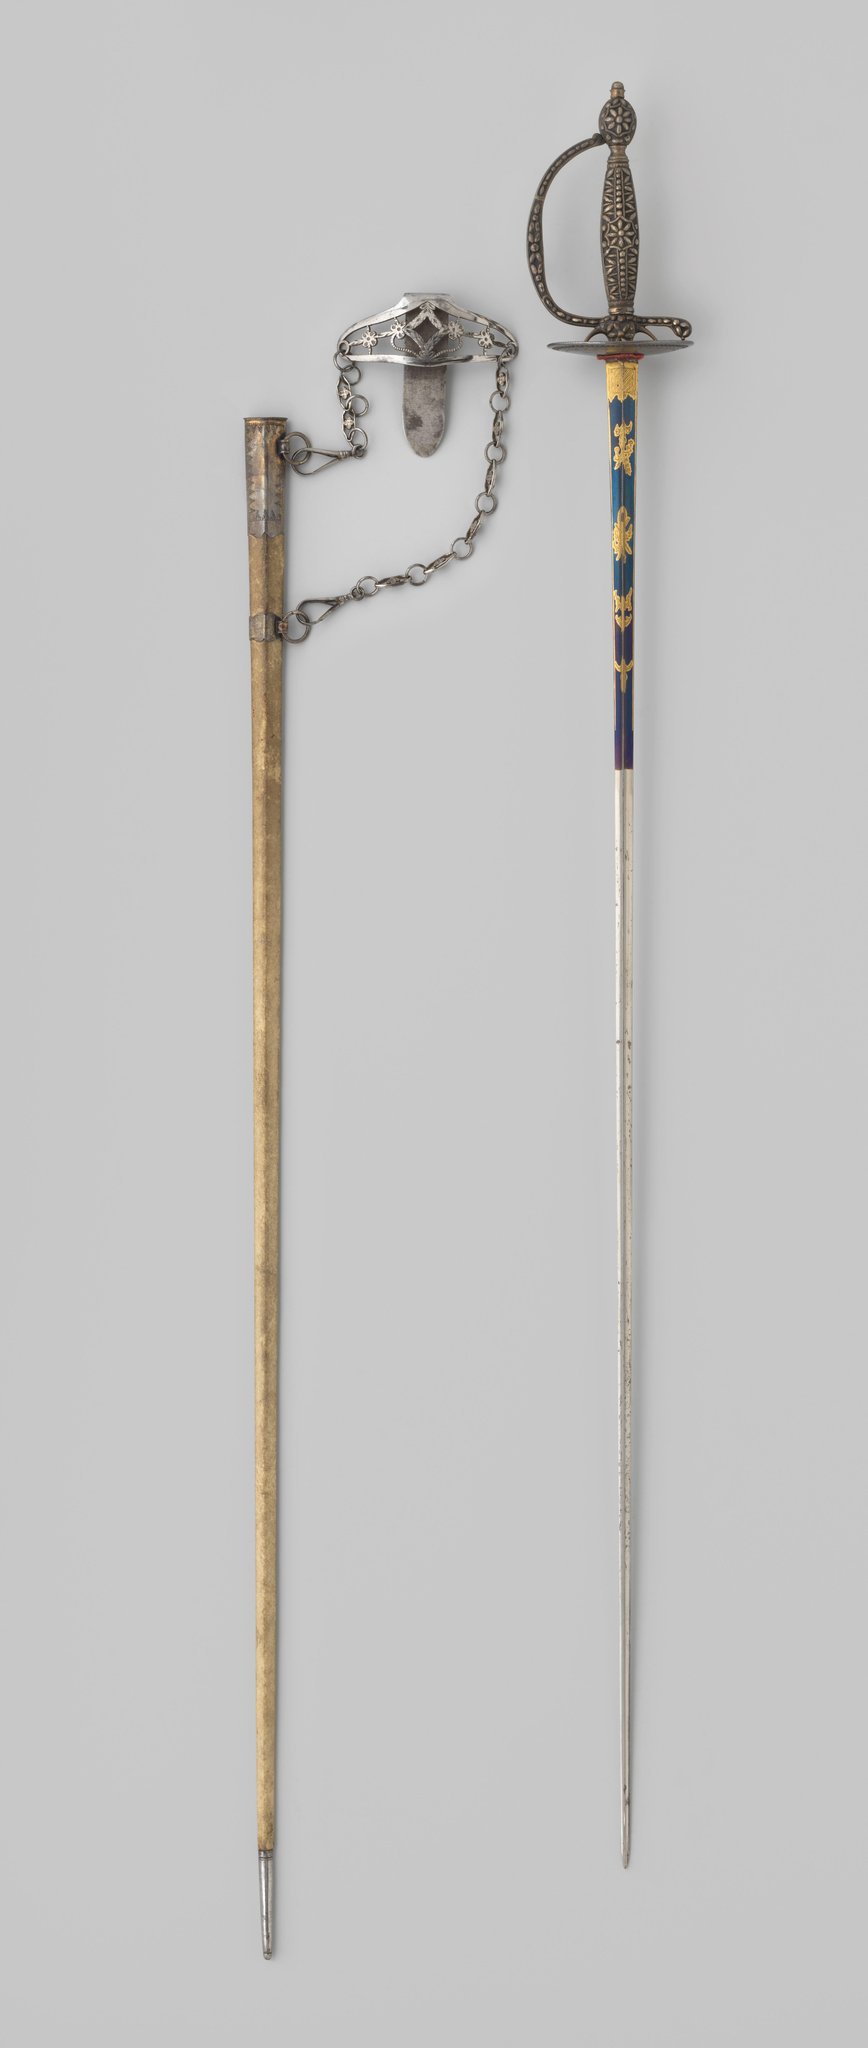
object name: menswear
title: Rouwdegen met geslepen zilveren gevest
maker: Anonymous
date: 1795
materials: silver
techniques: gilding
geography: paris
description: Rouwdegen met geslepen zilveren gevest met een greep en vuistbeugel met facetten en een driehoekige, deels blank geslepen en deels geblauwde en vergulde kling. Merken op de greep en op de beugel: a. een vrouwenkop met 1 b. een Romeinse kop met 5 (beide en-face) c. een haantje en 1 d. onduidelijk, o.a. een ster, is een onleesbaar meesterteken e. op beslag van de schede: een bijl in fascesbundel (=Parijs). A, B en C: Parijs, 1e gehalte (1798-1809). Merk: Parijs 1795 (op gevest).